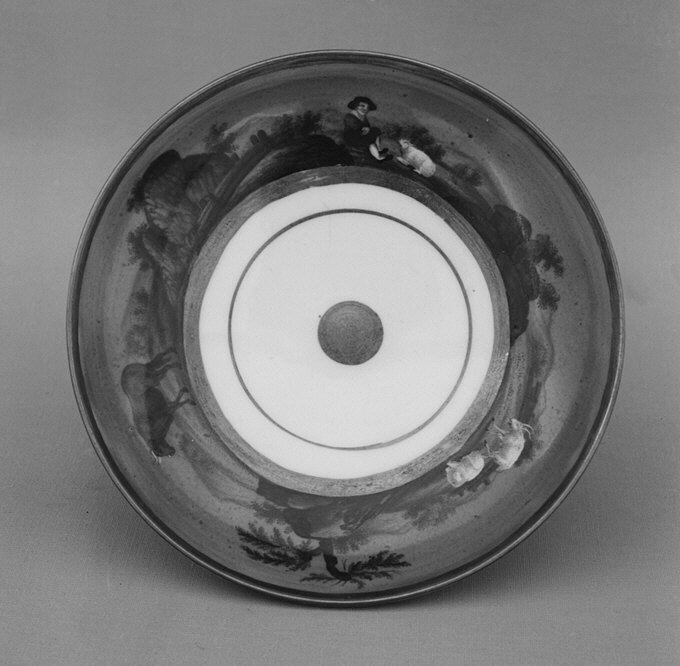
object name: saucer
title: Saucer (one of six) (part of a set)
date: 1820-1830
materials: hard paste porcelain